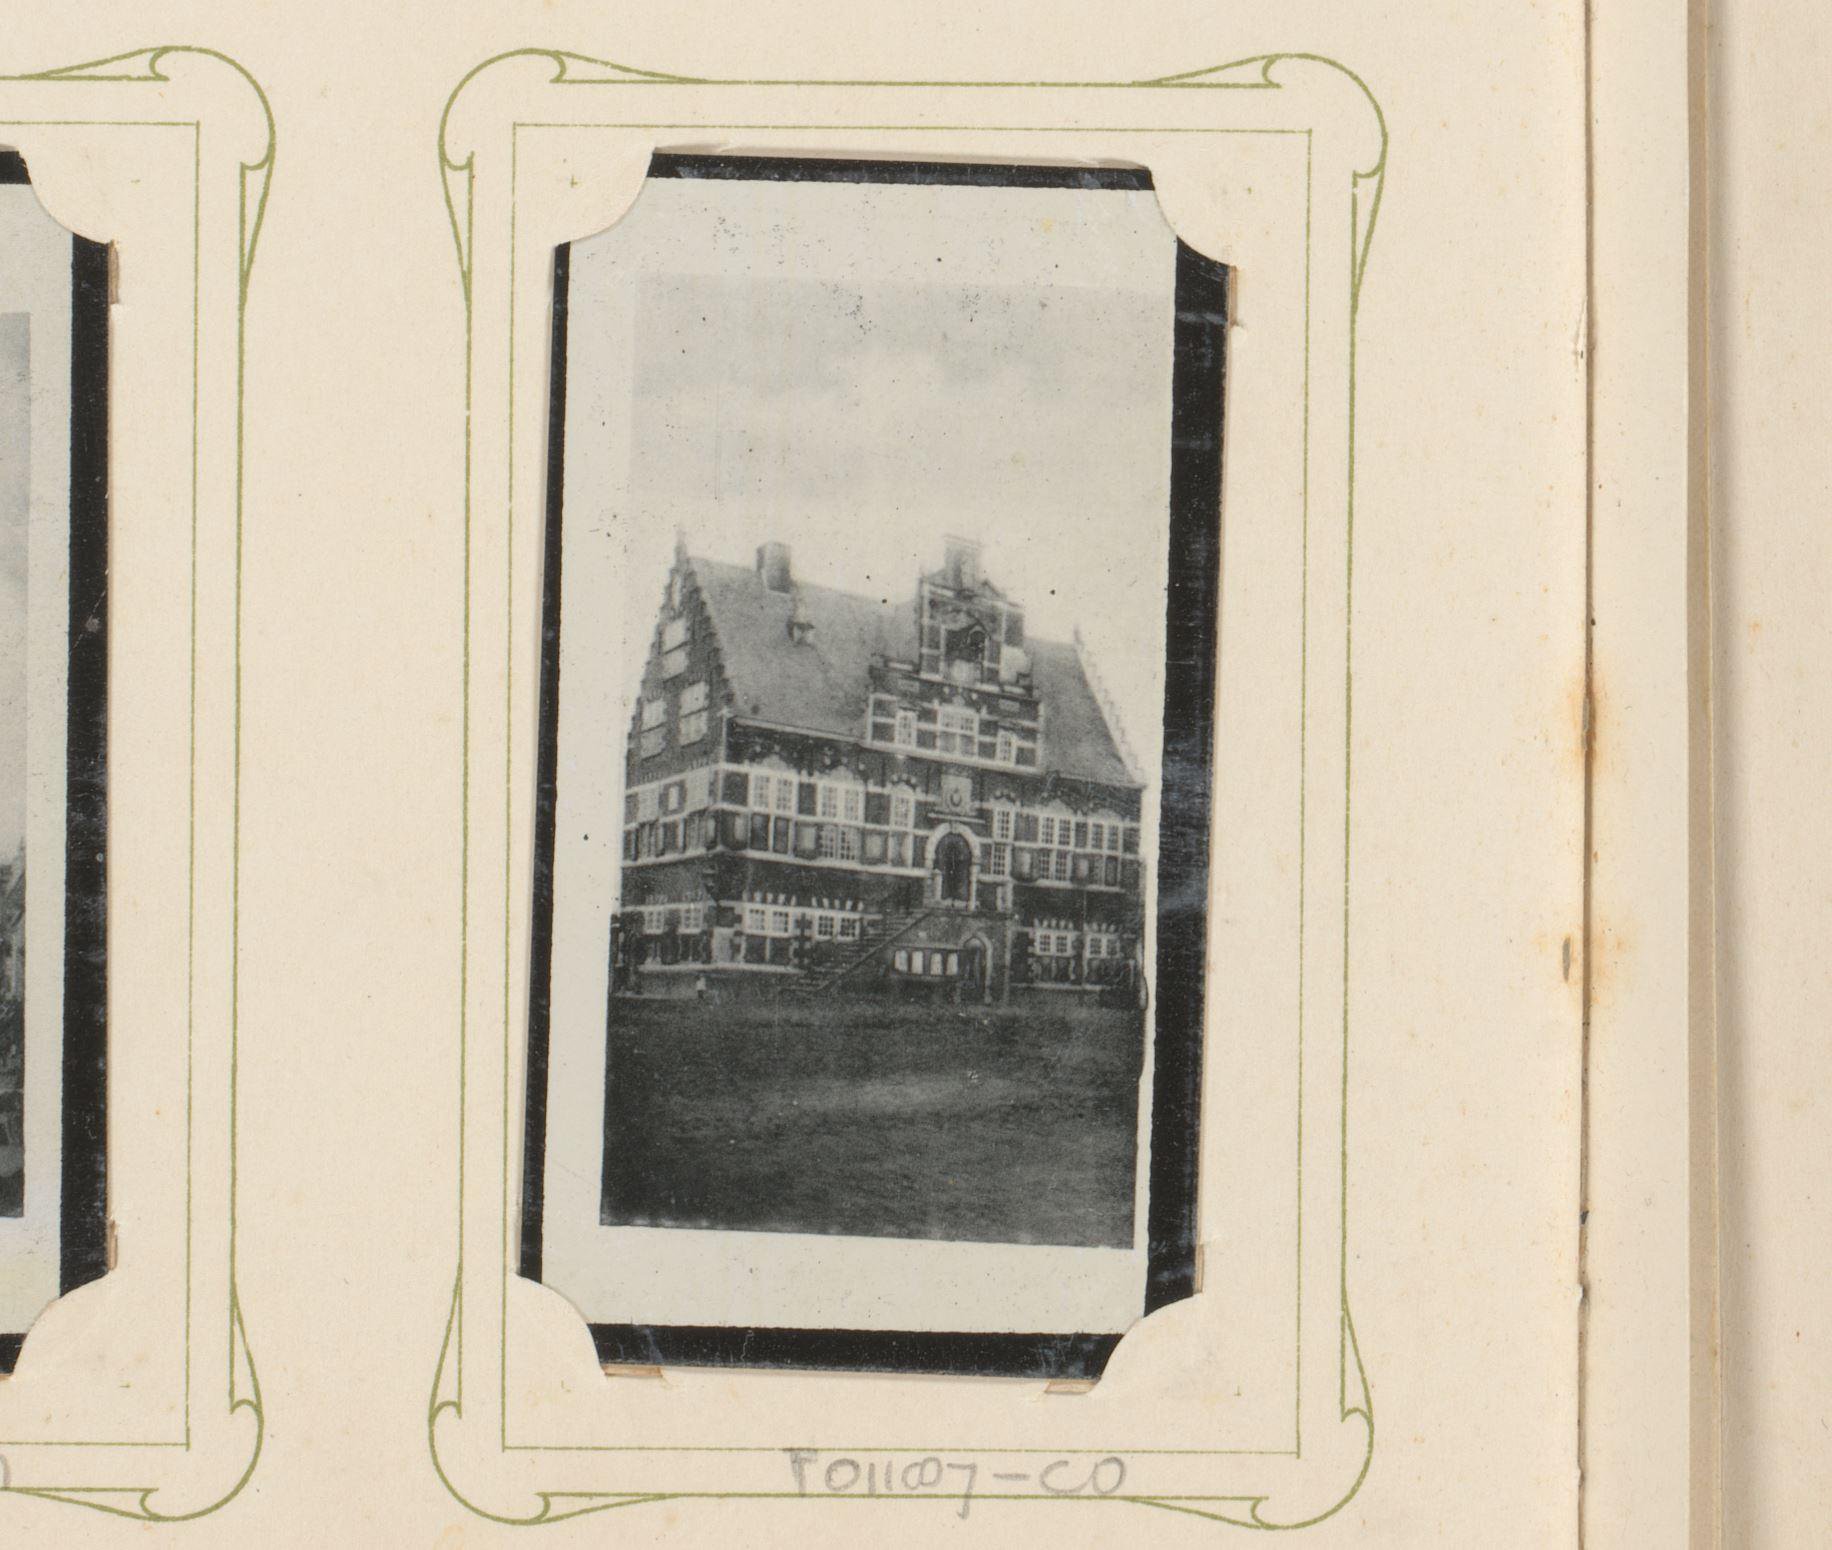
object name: album leaf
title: Gezicht op het stadhuis van Vlissingen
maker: Anonymous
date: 1905-1906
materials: paper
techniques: photograph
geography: klundert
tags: townhall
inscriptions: inscription: ‘No. 6./ Stadhuis te Klundert.’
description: Deze prent maakt deel uit van een album.